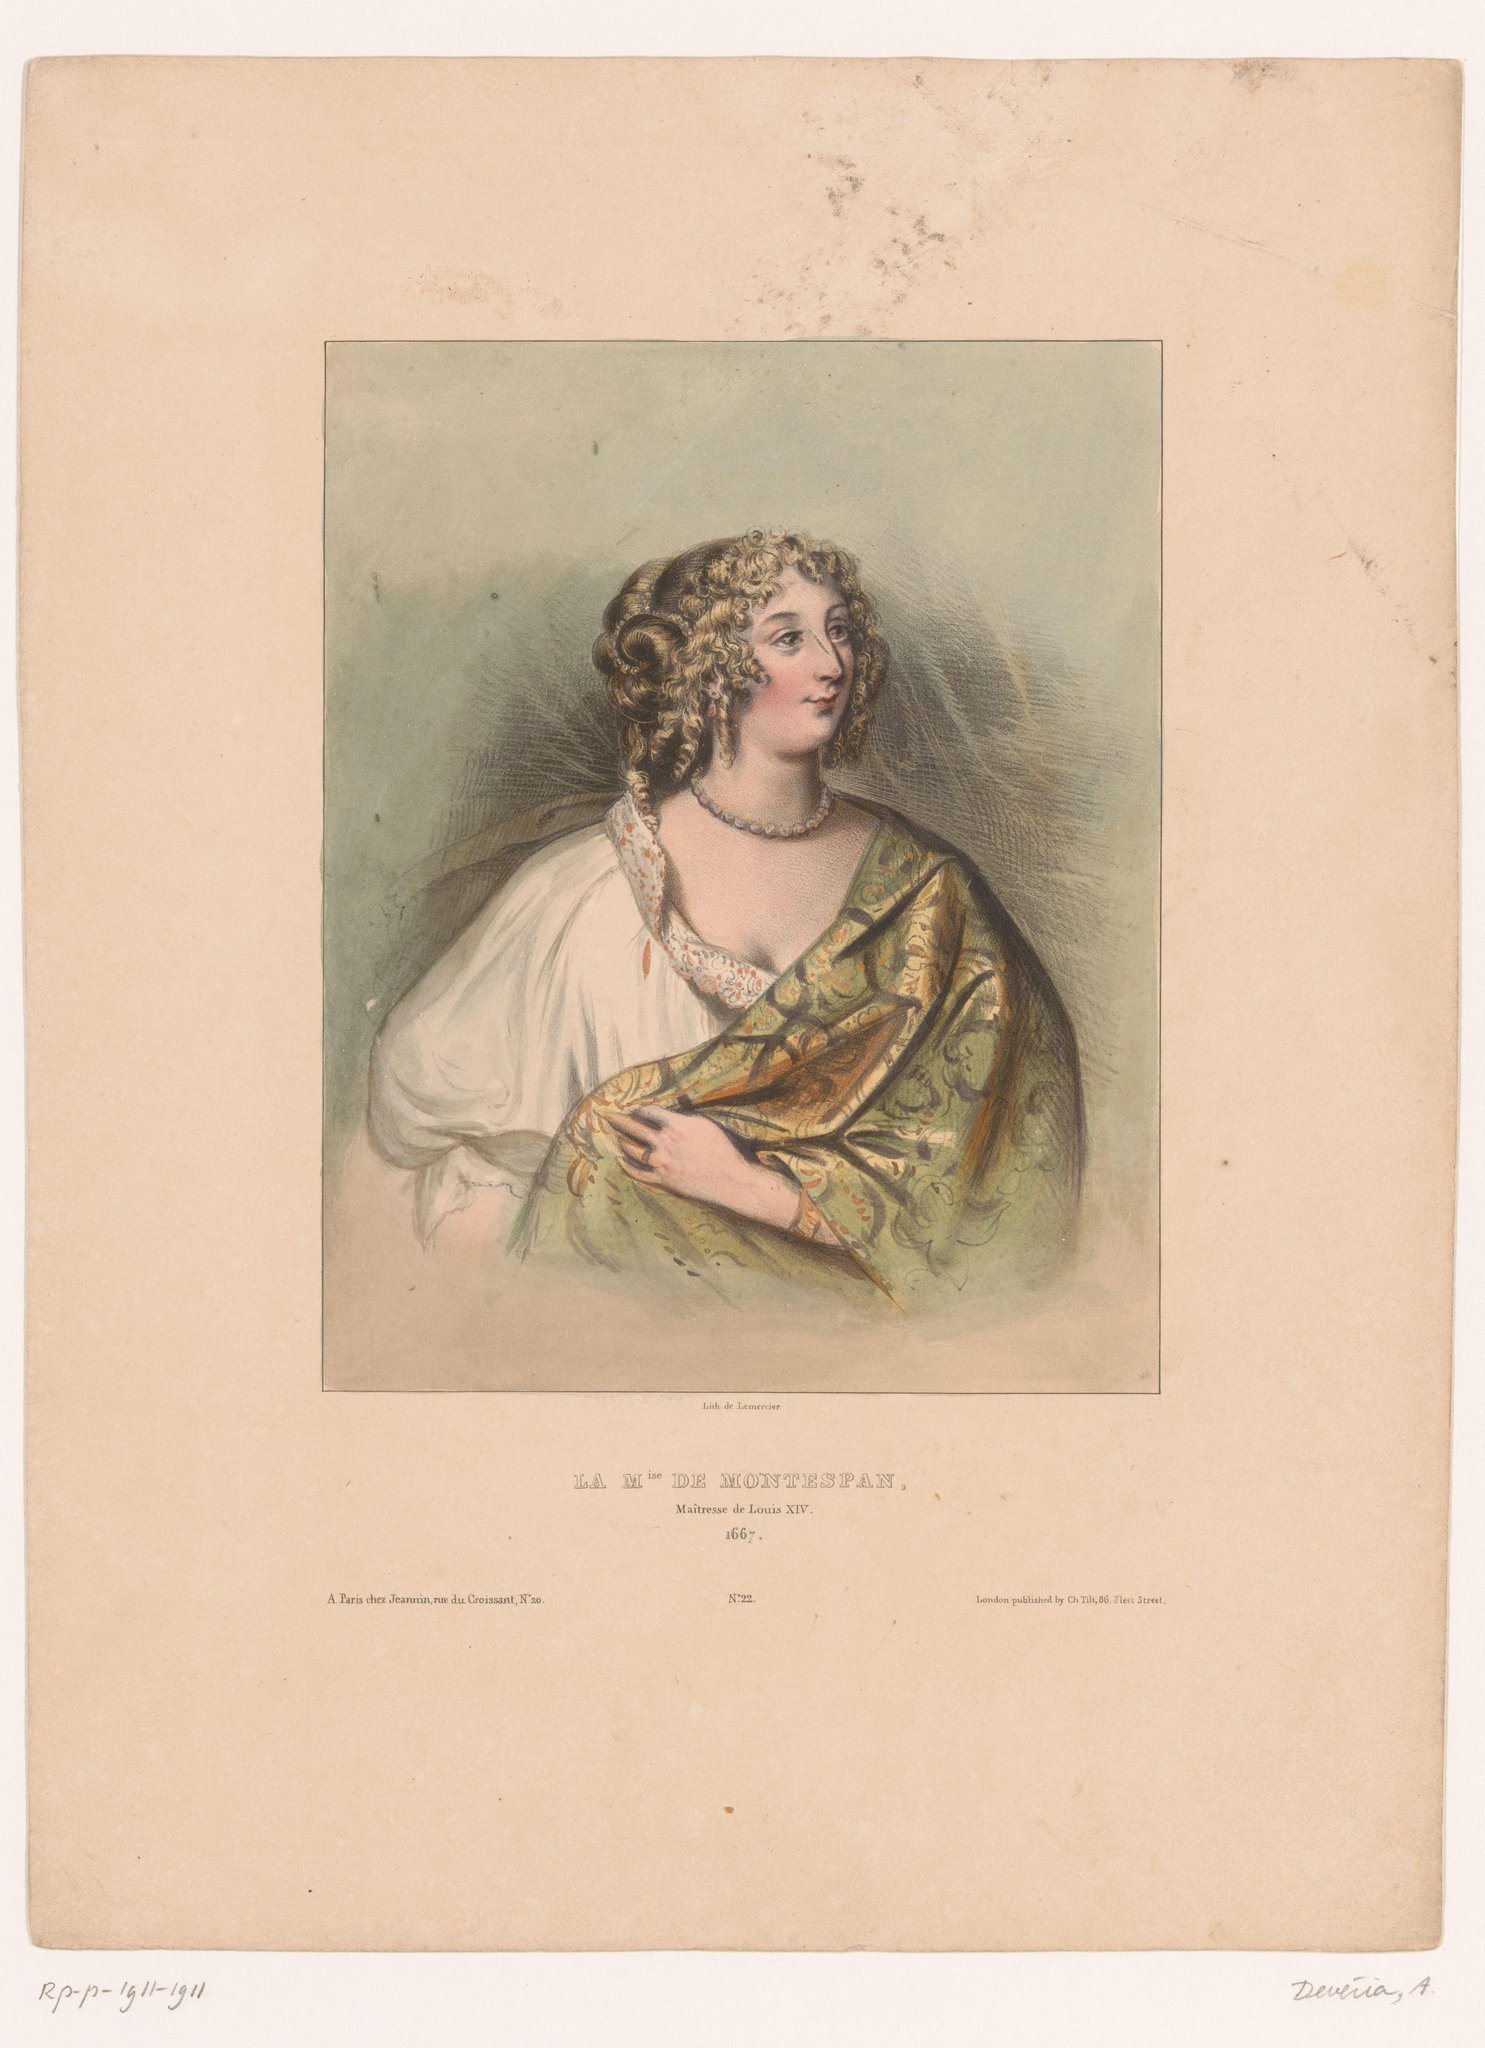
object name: print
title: Beroemde vrouwen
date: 1832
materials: paper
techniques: hand coloring, lithograph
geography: paris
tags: françoise-athénaïs (marquise de montespan), historical persons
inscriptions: check stamp: Lugt 3987, collector's mark: Lugt 2228a